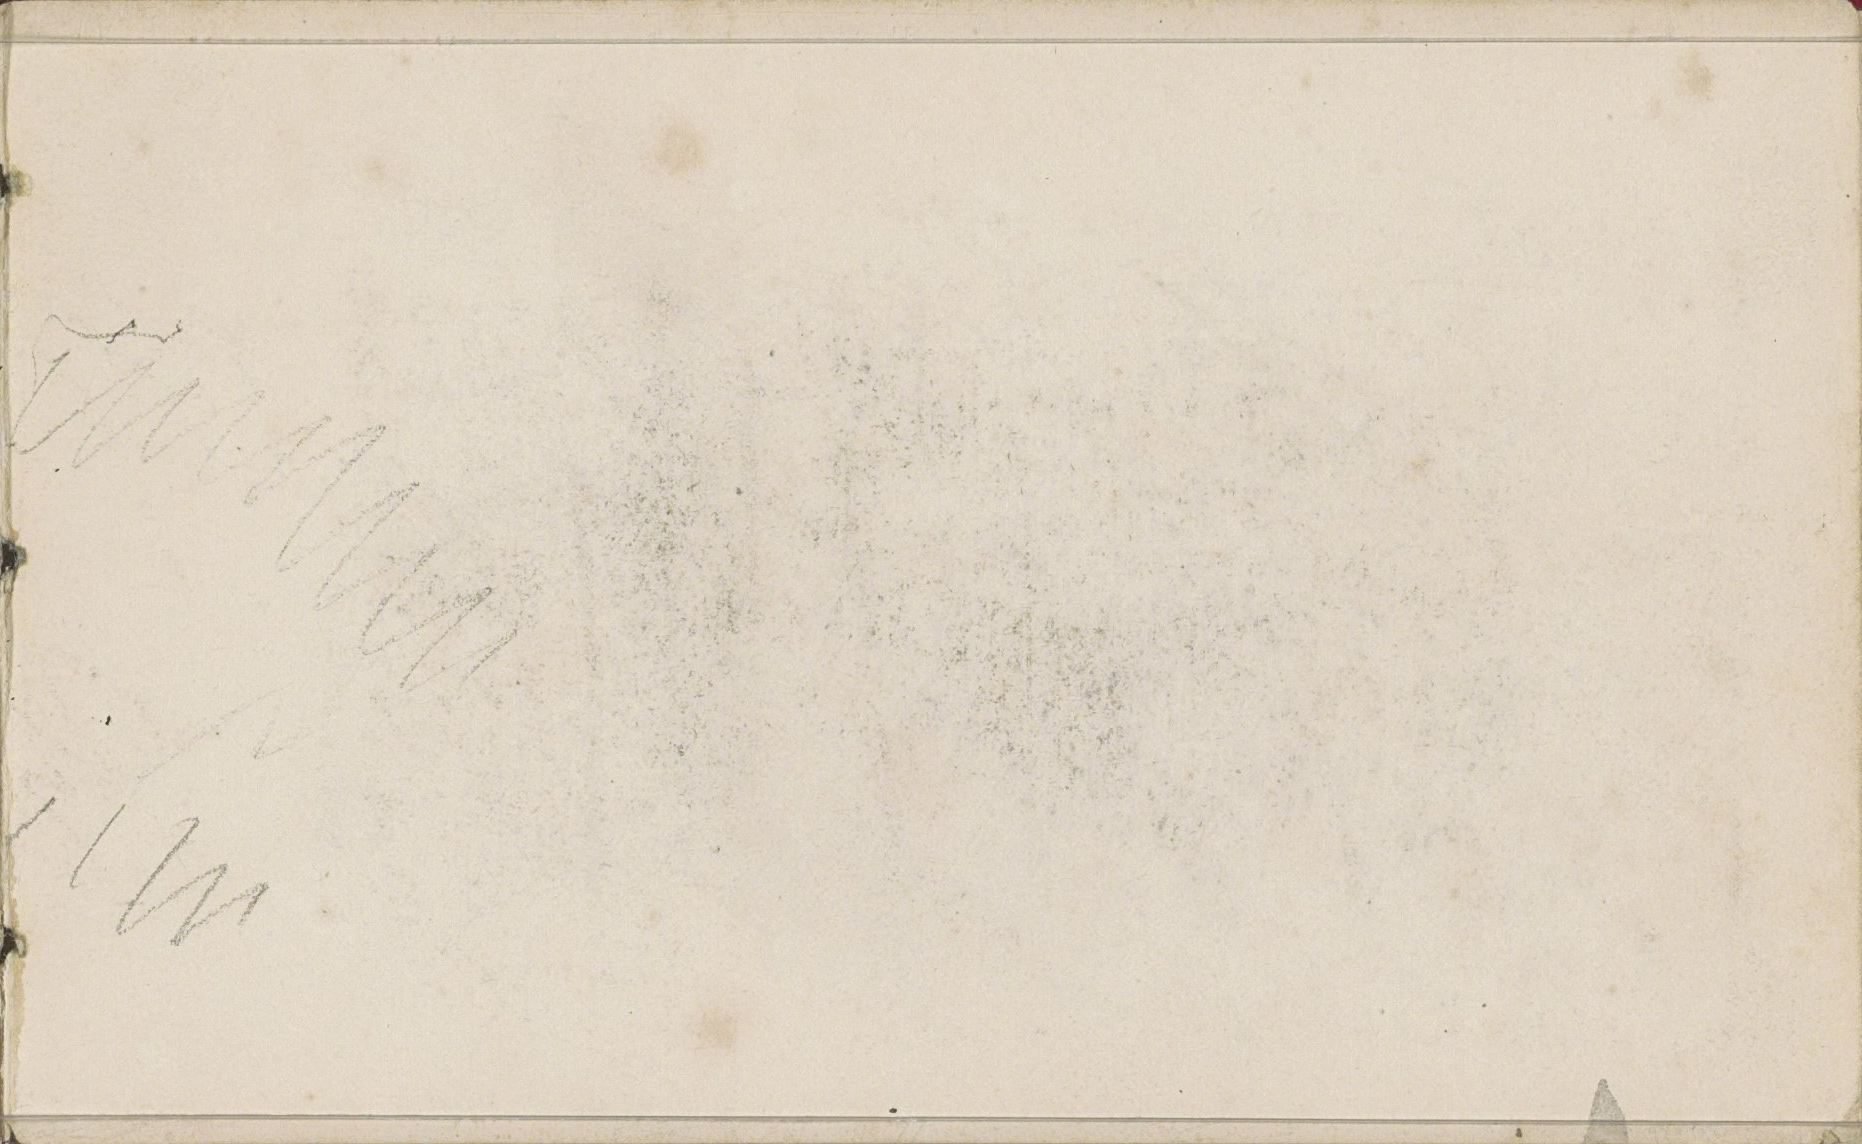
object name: sketchbook leaf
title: Studie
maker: anton mauve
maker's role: draughtsman, painter, print maker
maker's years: 1838-1888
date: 1876-1888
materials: paper, pencil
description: Blad 34 recto uit een schetsboek met 34 bladen.